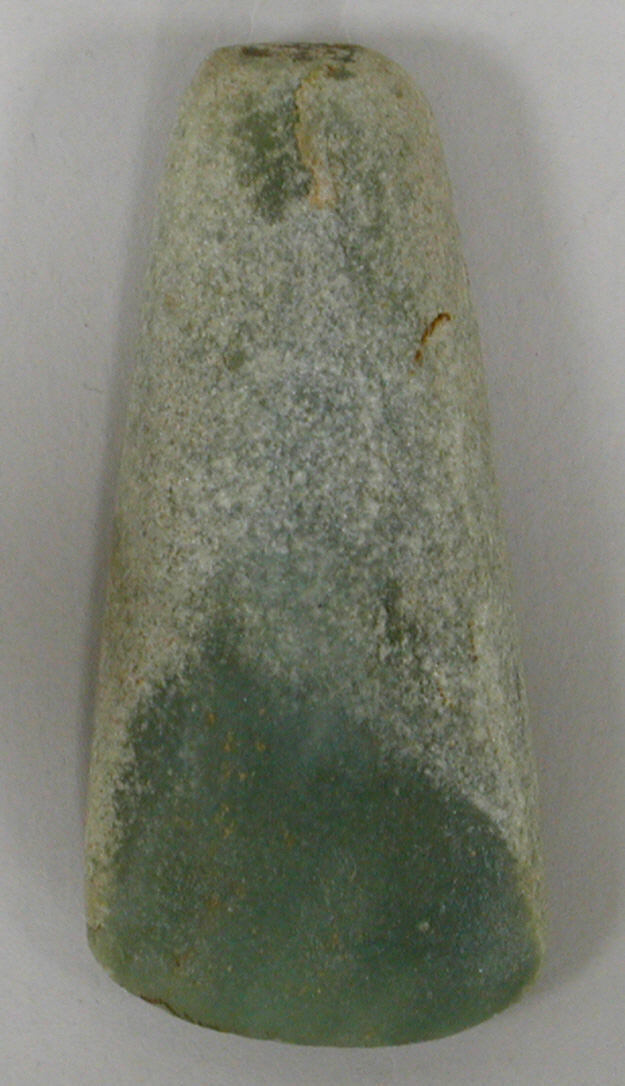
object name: celt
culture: maya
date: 1501-1600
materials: stone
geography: guatemala